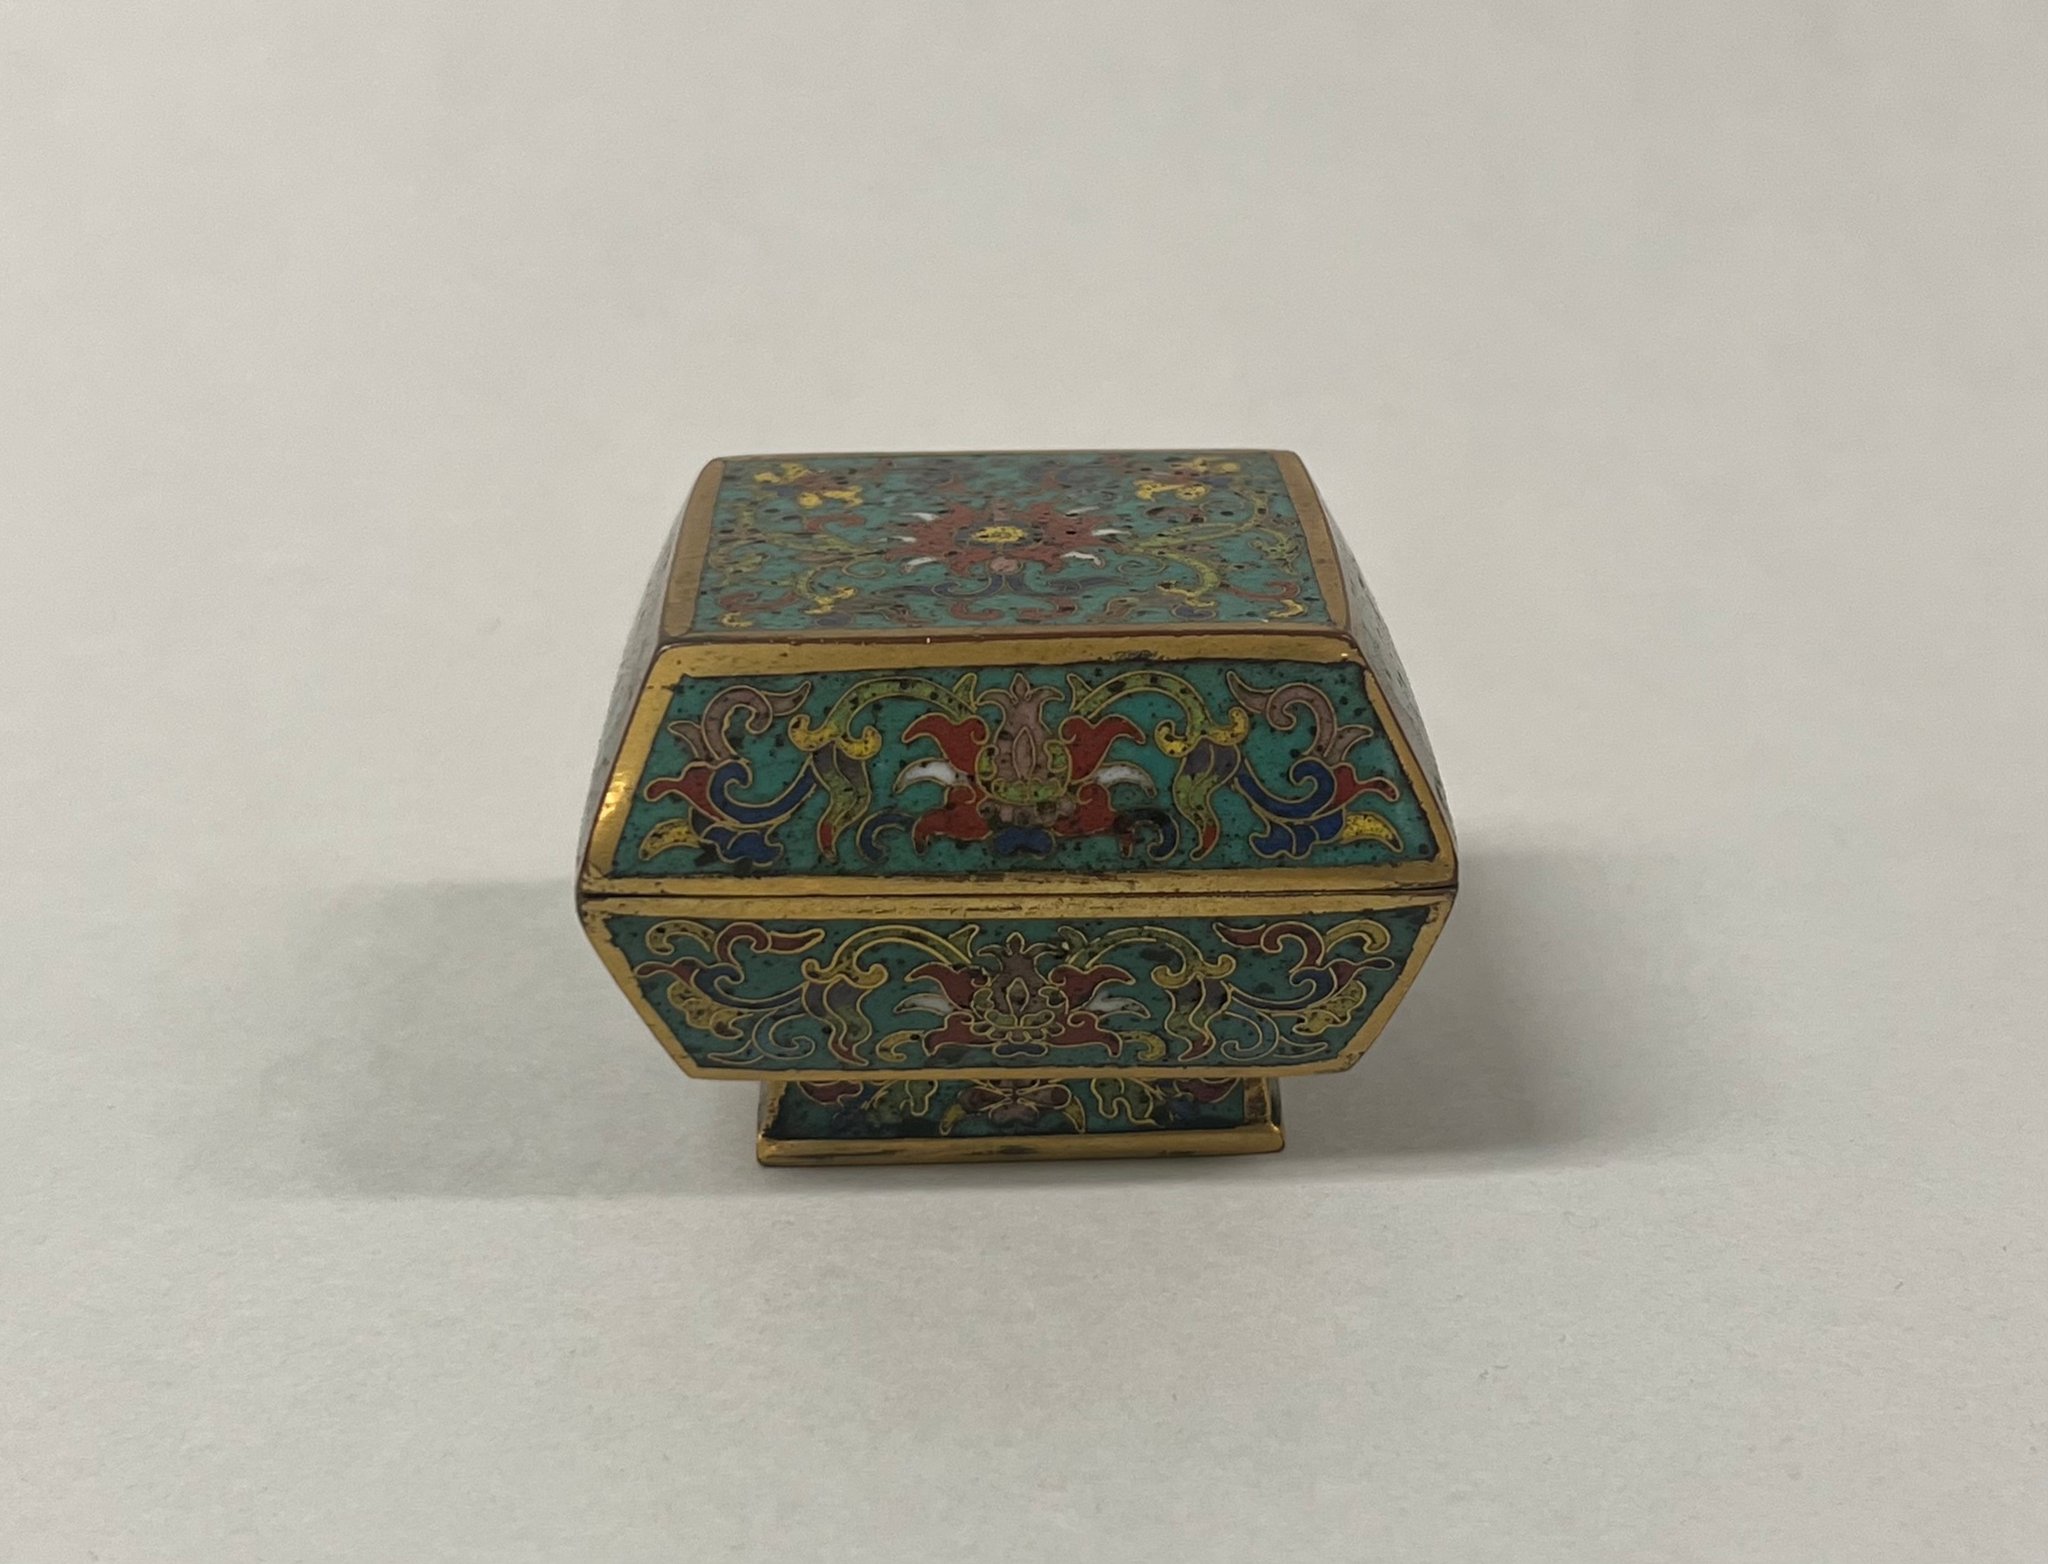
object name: covered box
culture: chinese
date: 1667-1733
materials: enamel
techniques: enamel